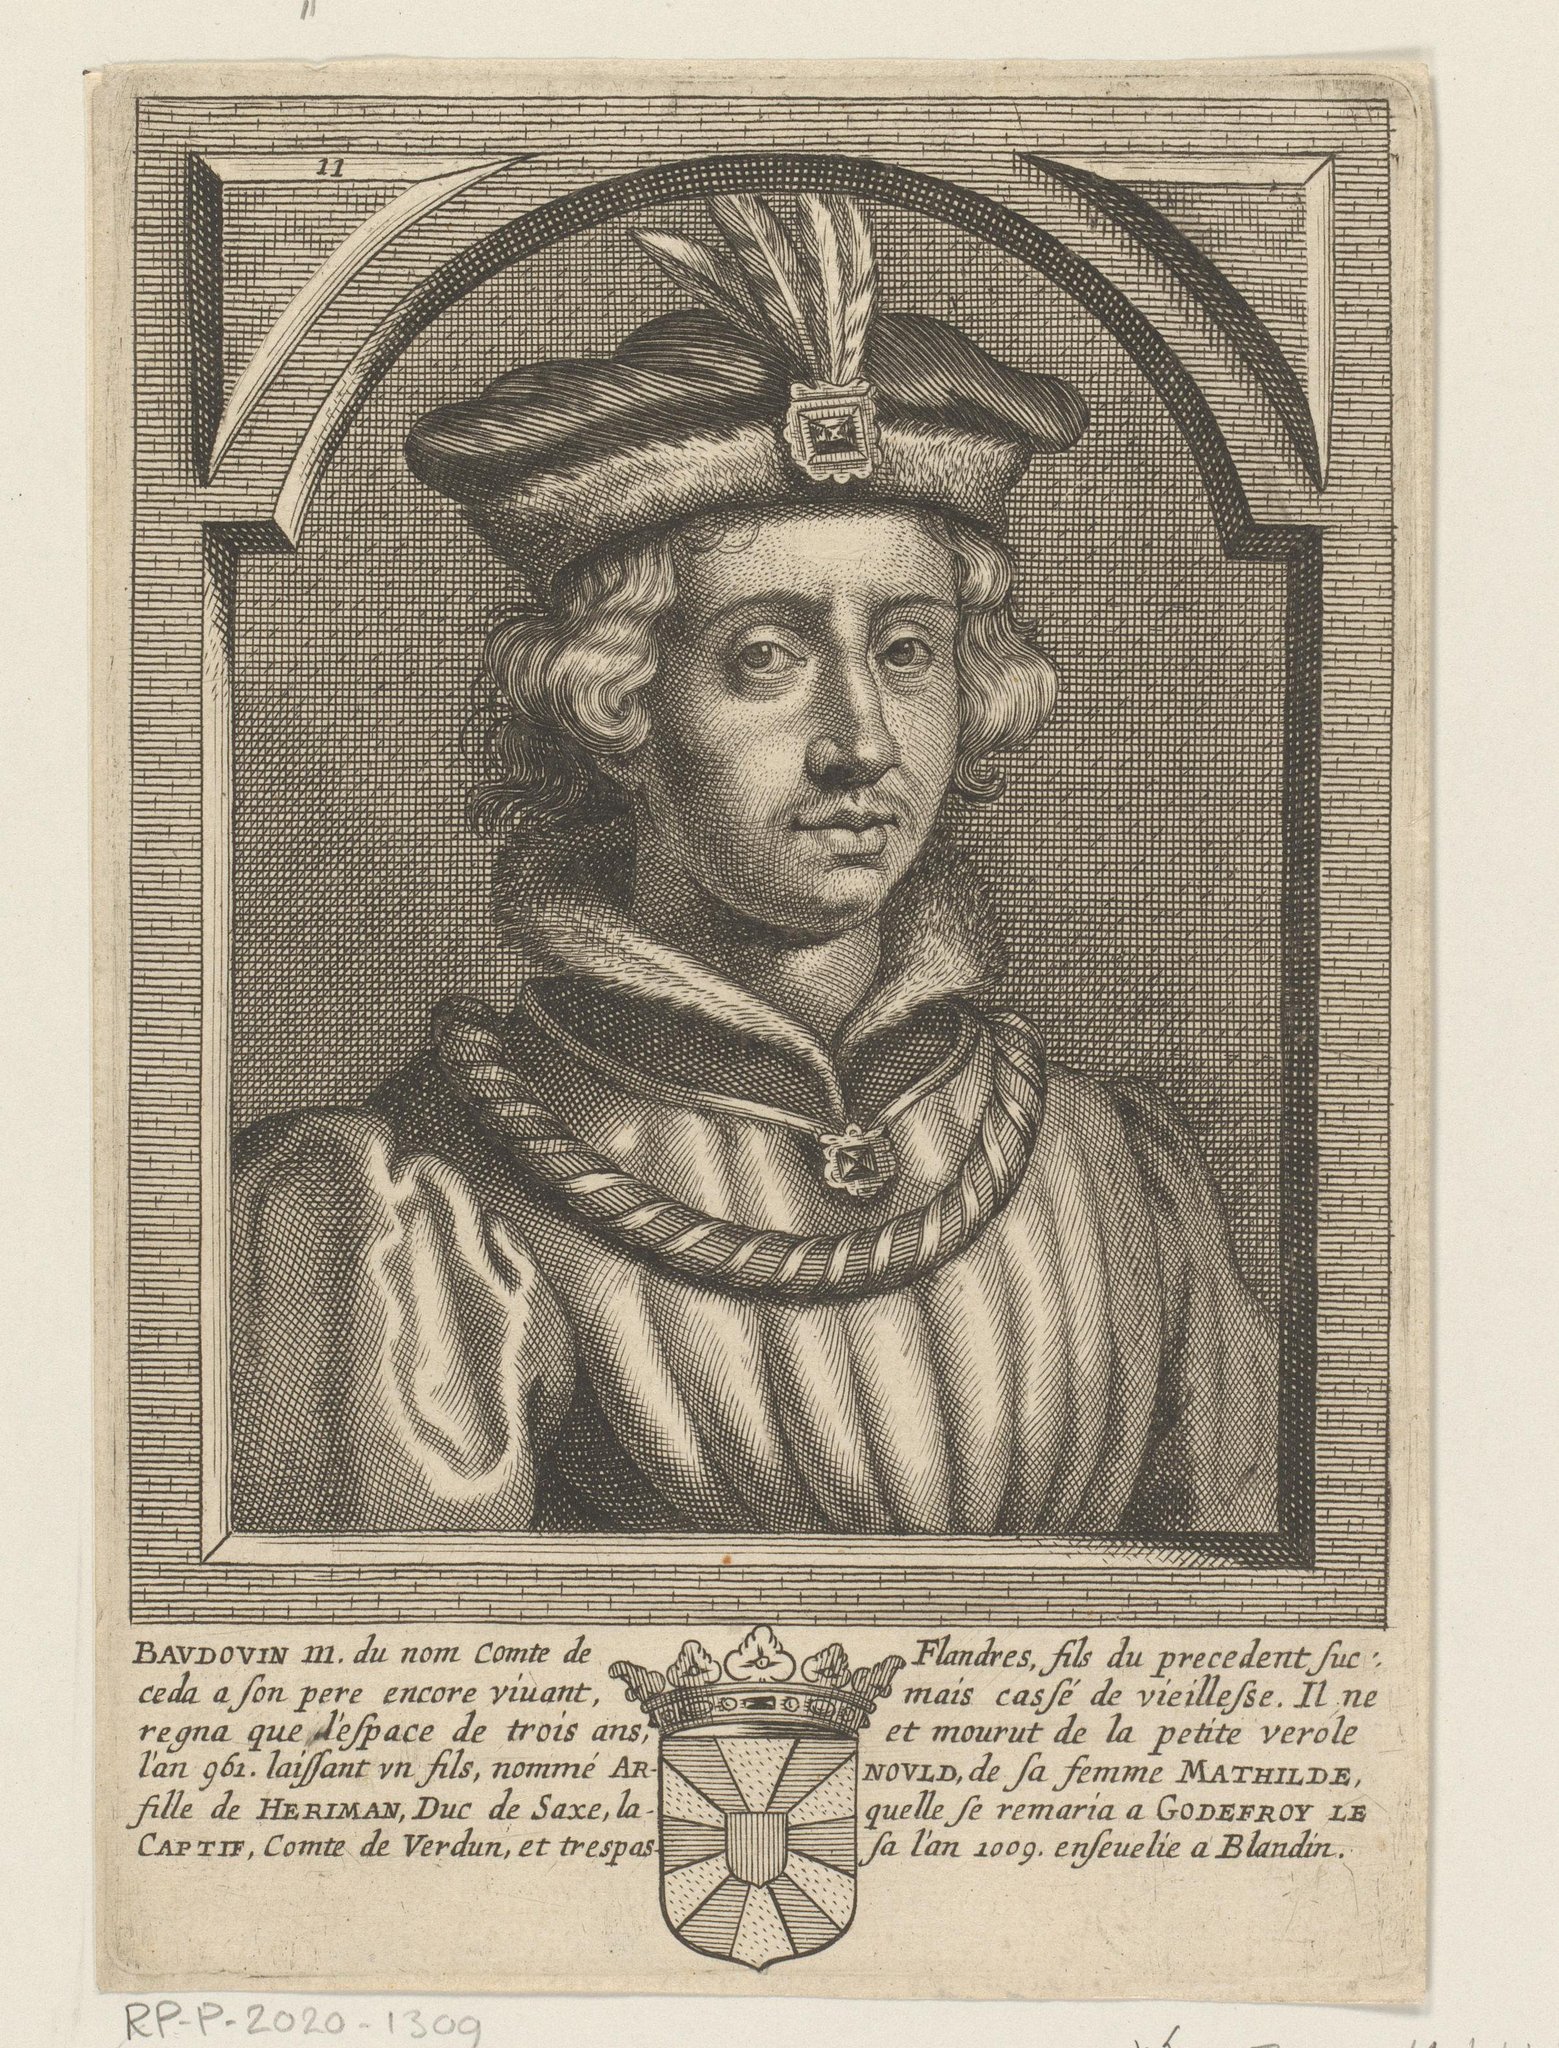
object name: print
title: Portret van Boudewijn III, graaf van Vlaanderen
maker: cornelis meyssens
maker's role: print maker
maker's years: 1640-1673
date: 1663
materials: paper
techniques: engraving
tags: earl, historical persons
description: Prent ook gebruikt in: Meyssens, Joannes. Effigies des forestiers et comtes de Flandres. Antwerpen: Joannes Meyssens, 1663.